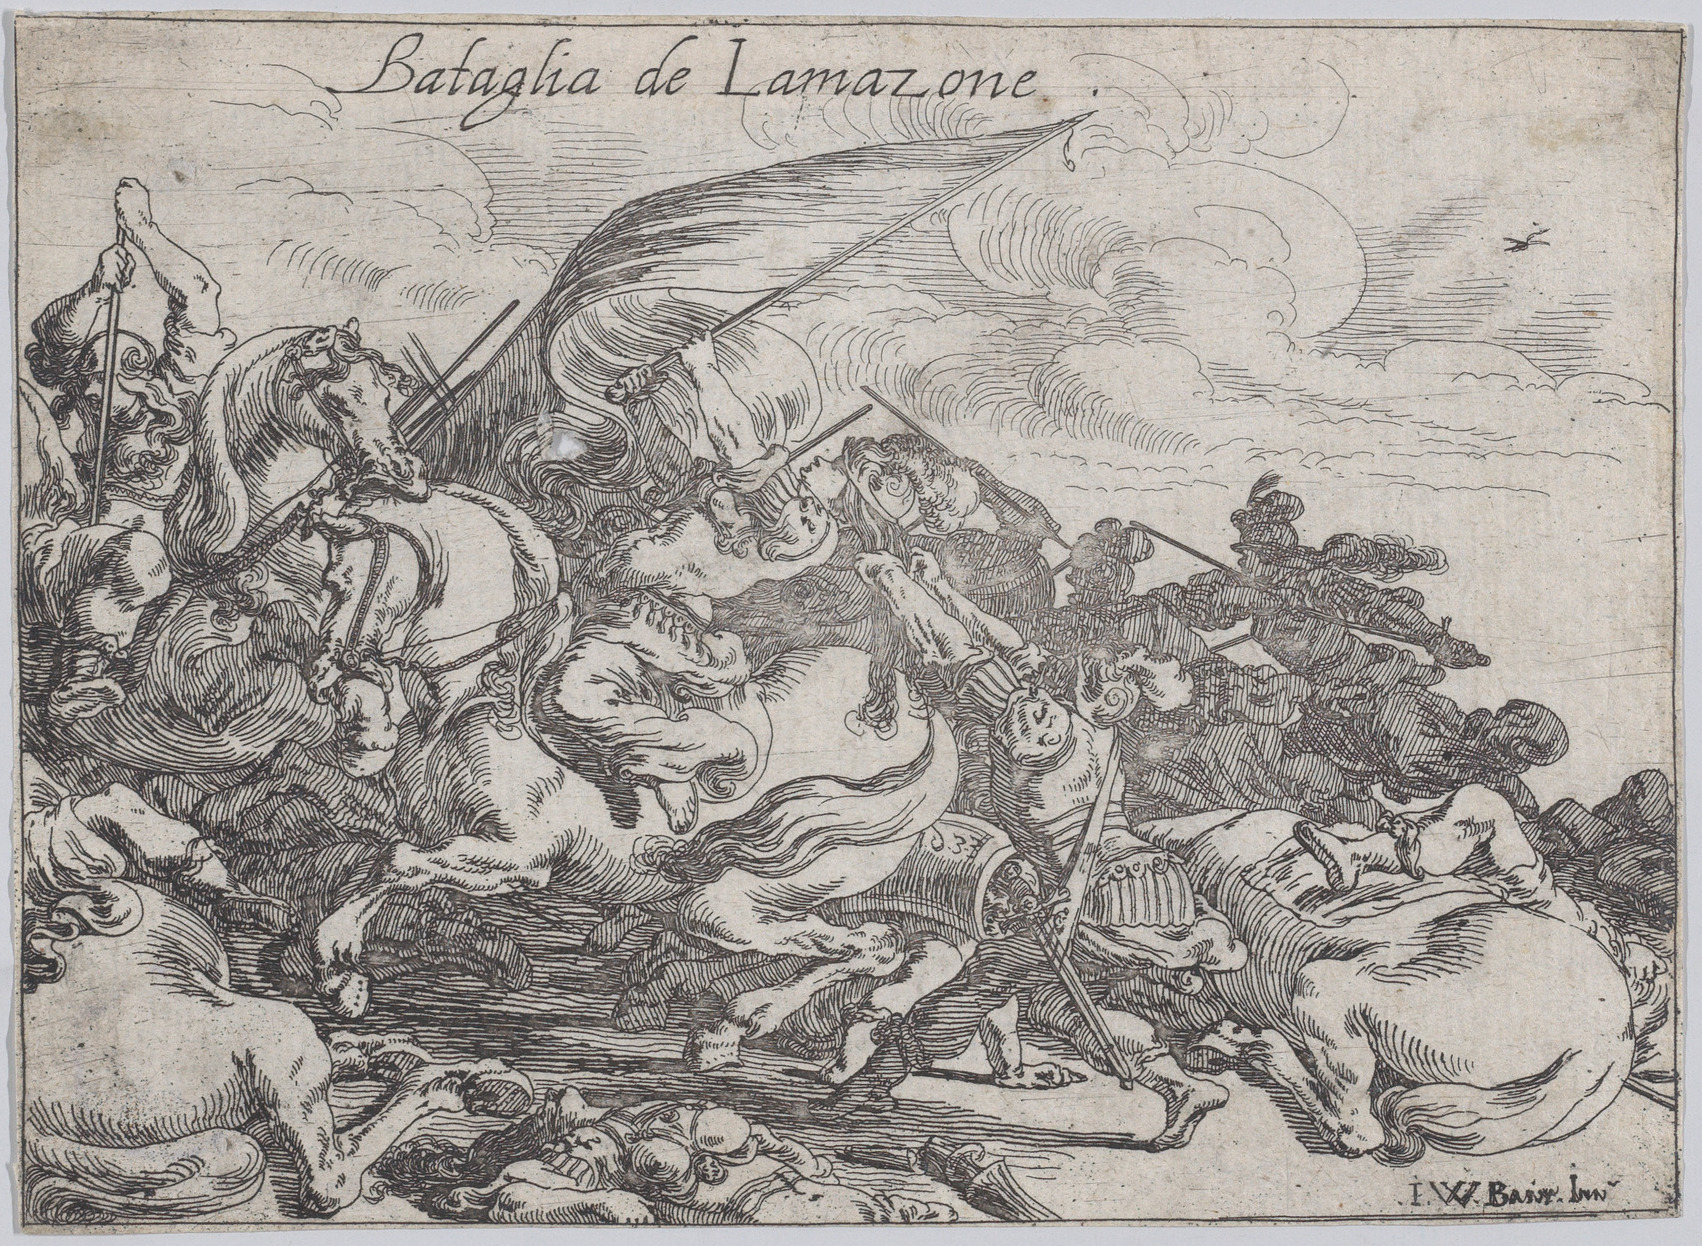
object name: print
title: Bataglia de L'Amazone, from "Battles of Different Nations" (Capricci di varie battaglie)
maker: johann wilhelm baur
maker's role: artist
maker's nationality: german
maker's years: 1607-1642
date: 1633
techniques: etching